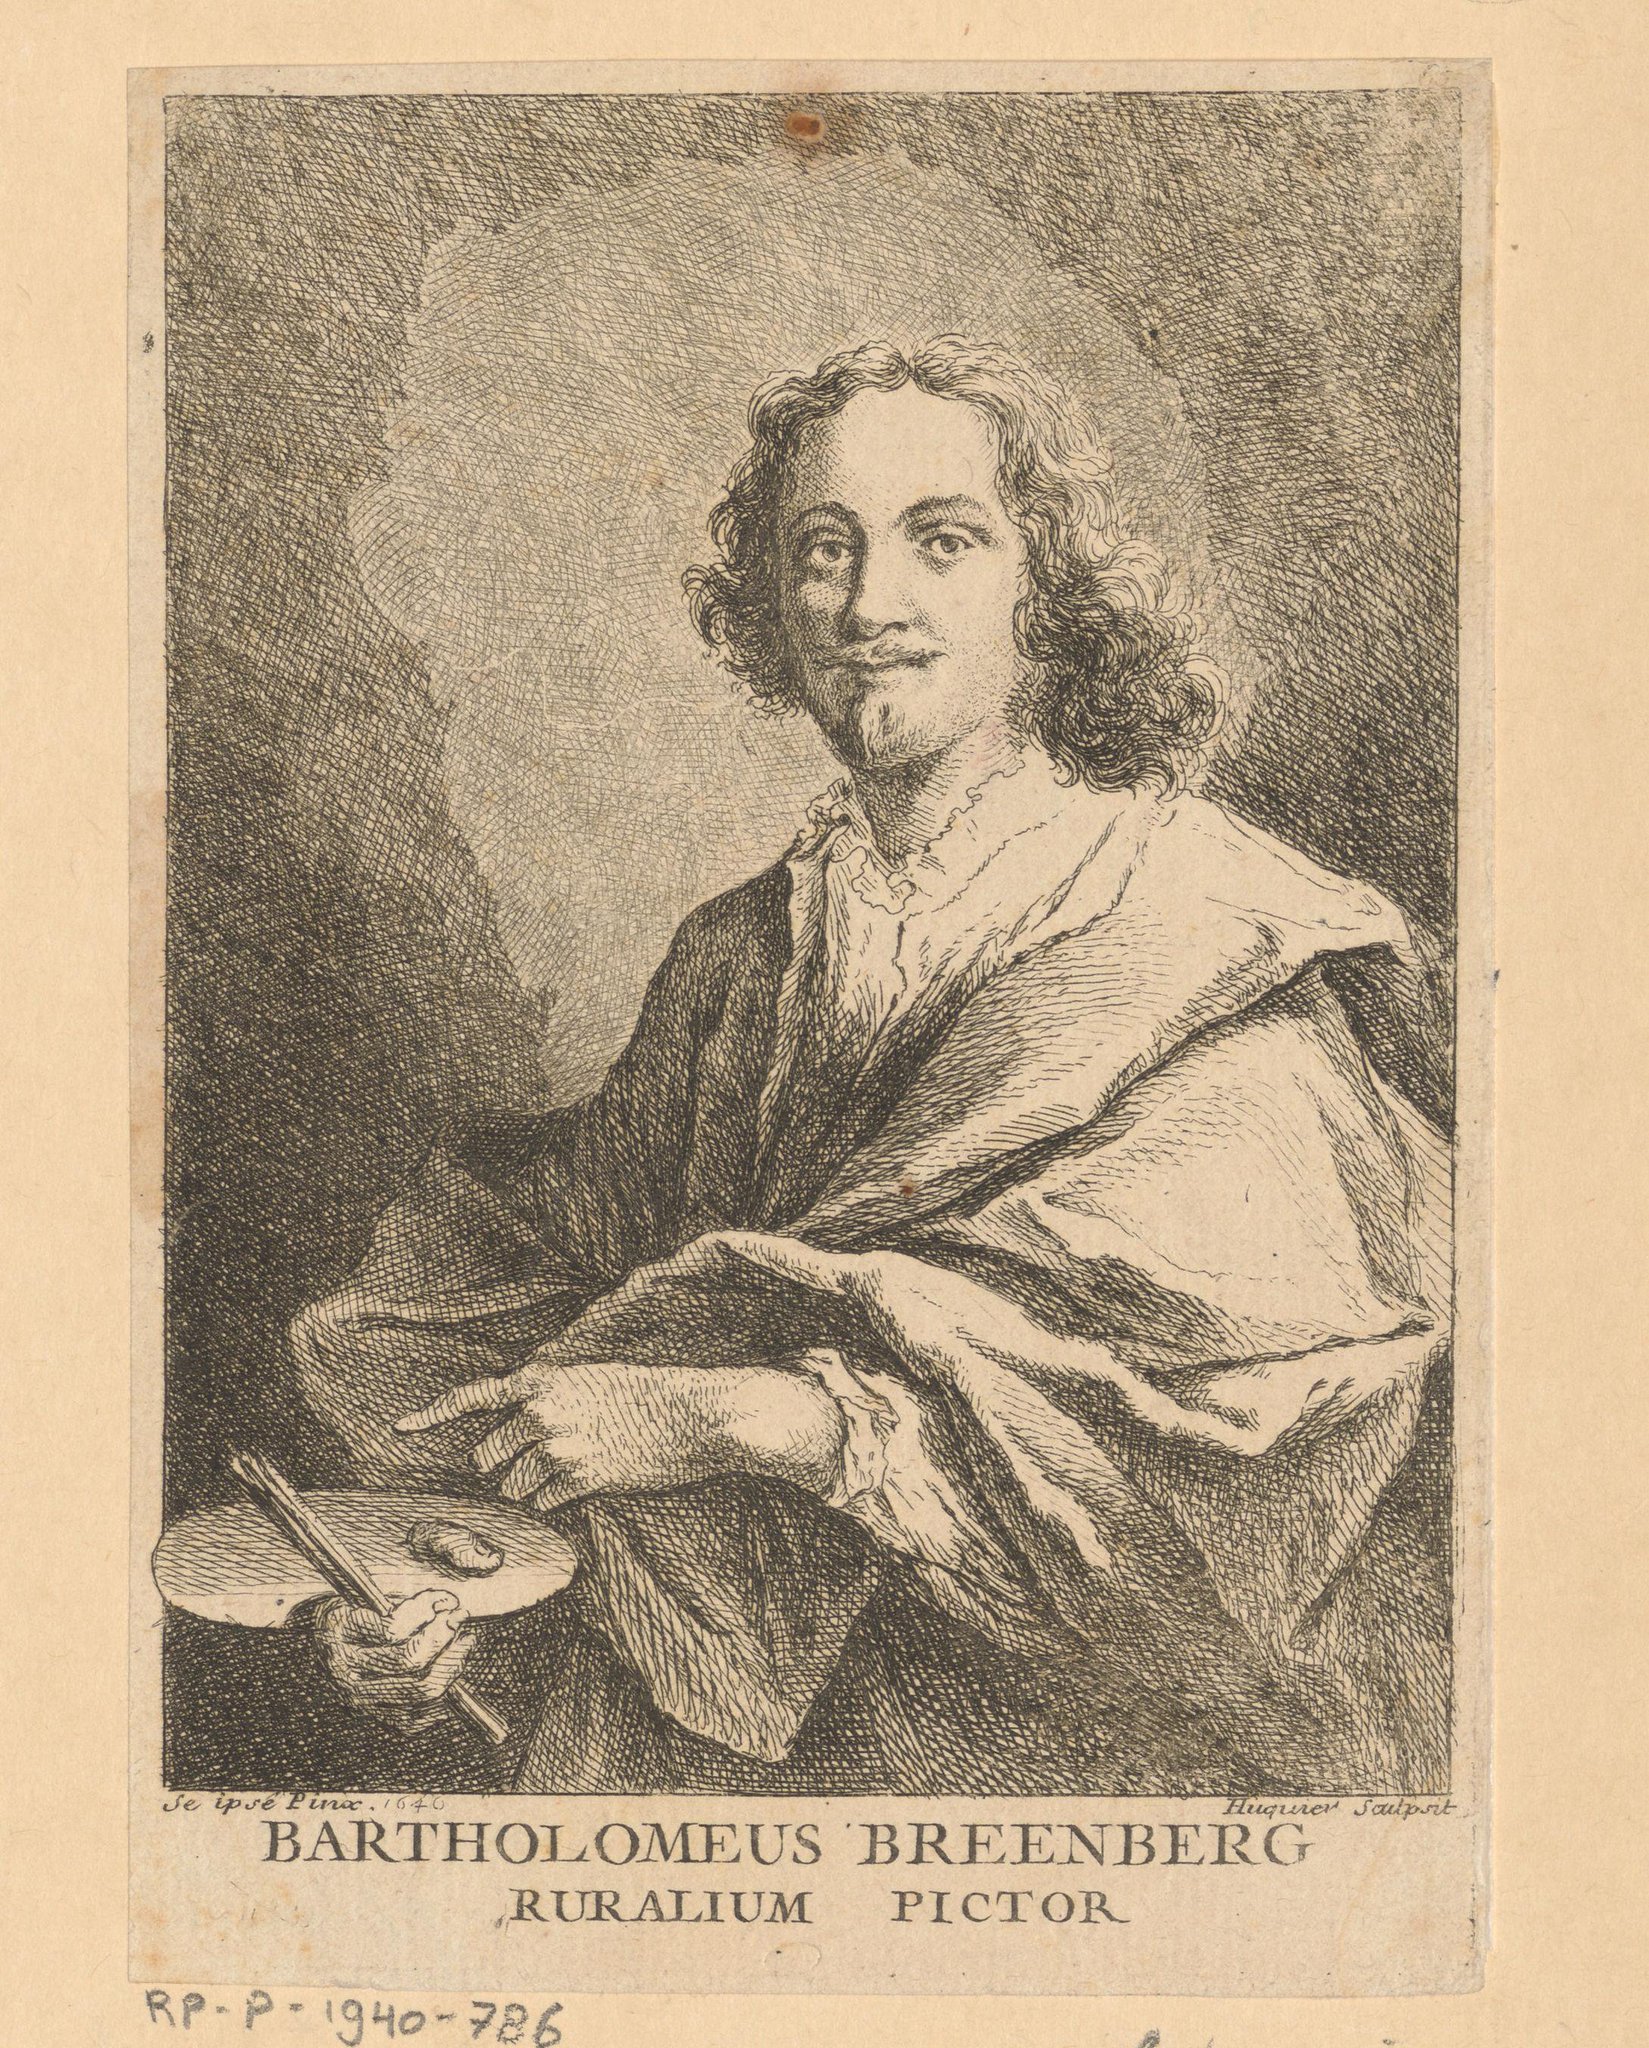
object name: print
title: Portret van Bartholomeus Breenbergh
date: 1735-1805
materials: paper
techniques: engraving, etching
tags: deventer, amsterdam, print maker, draughtsman, bartholomeus breenbergh, historical persons, portrait, self-portrait of painter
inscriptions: collector's mark: Lugt 2228, collector's mark: Lugt 2760